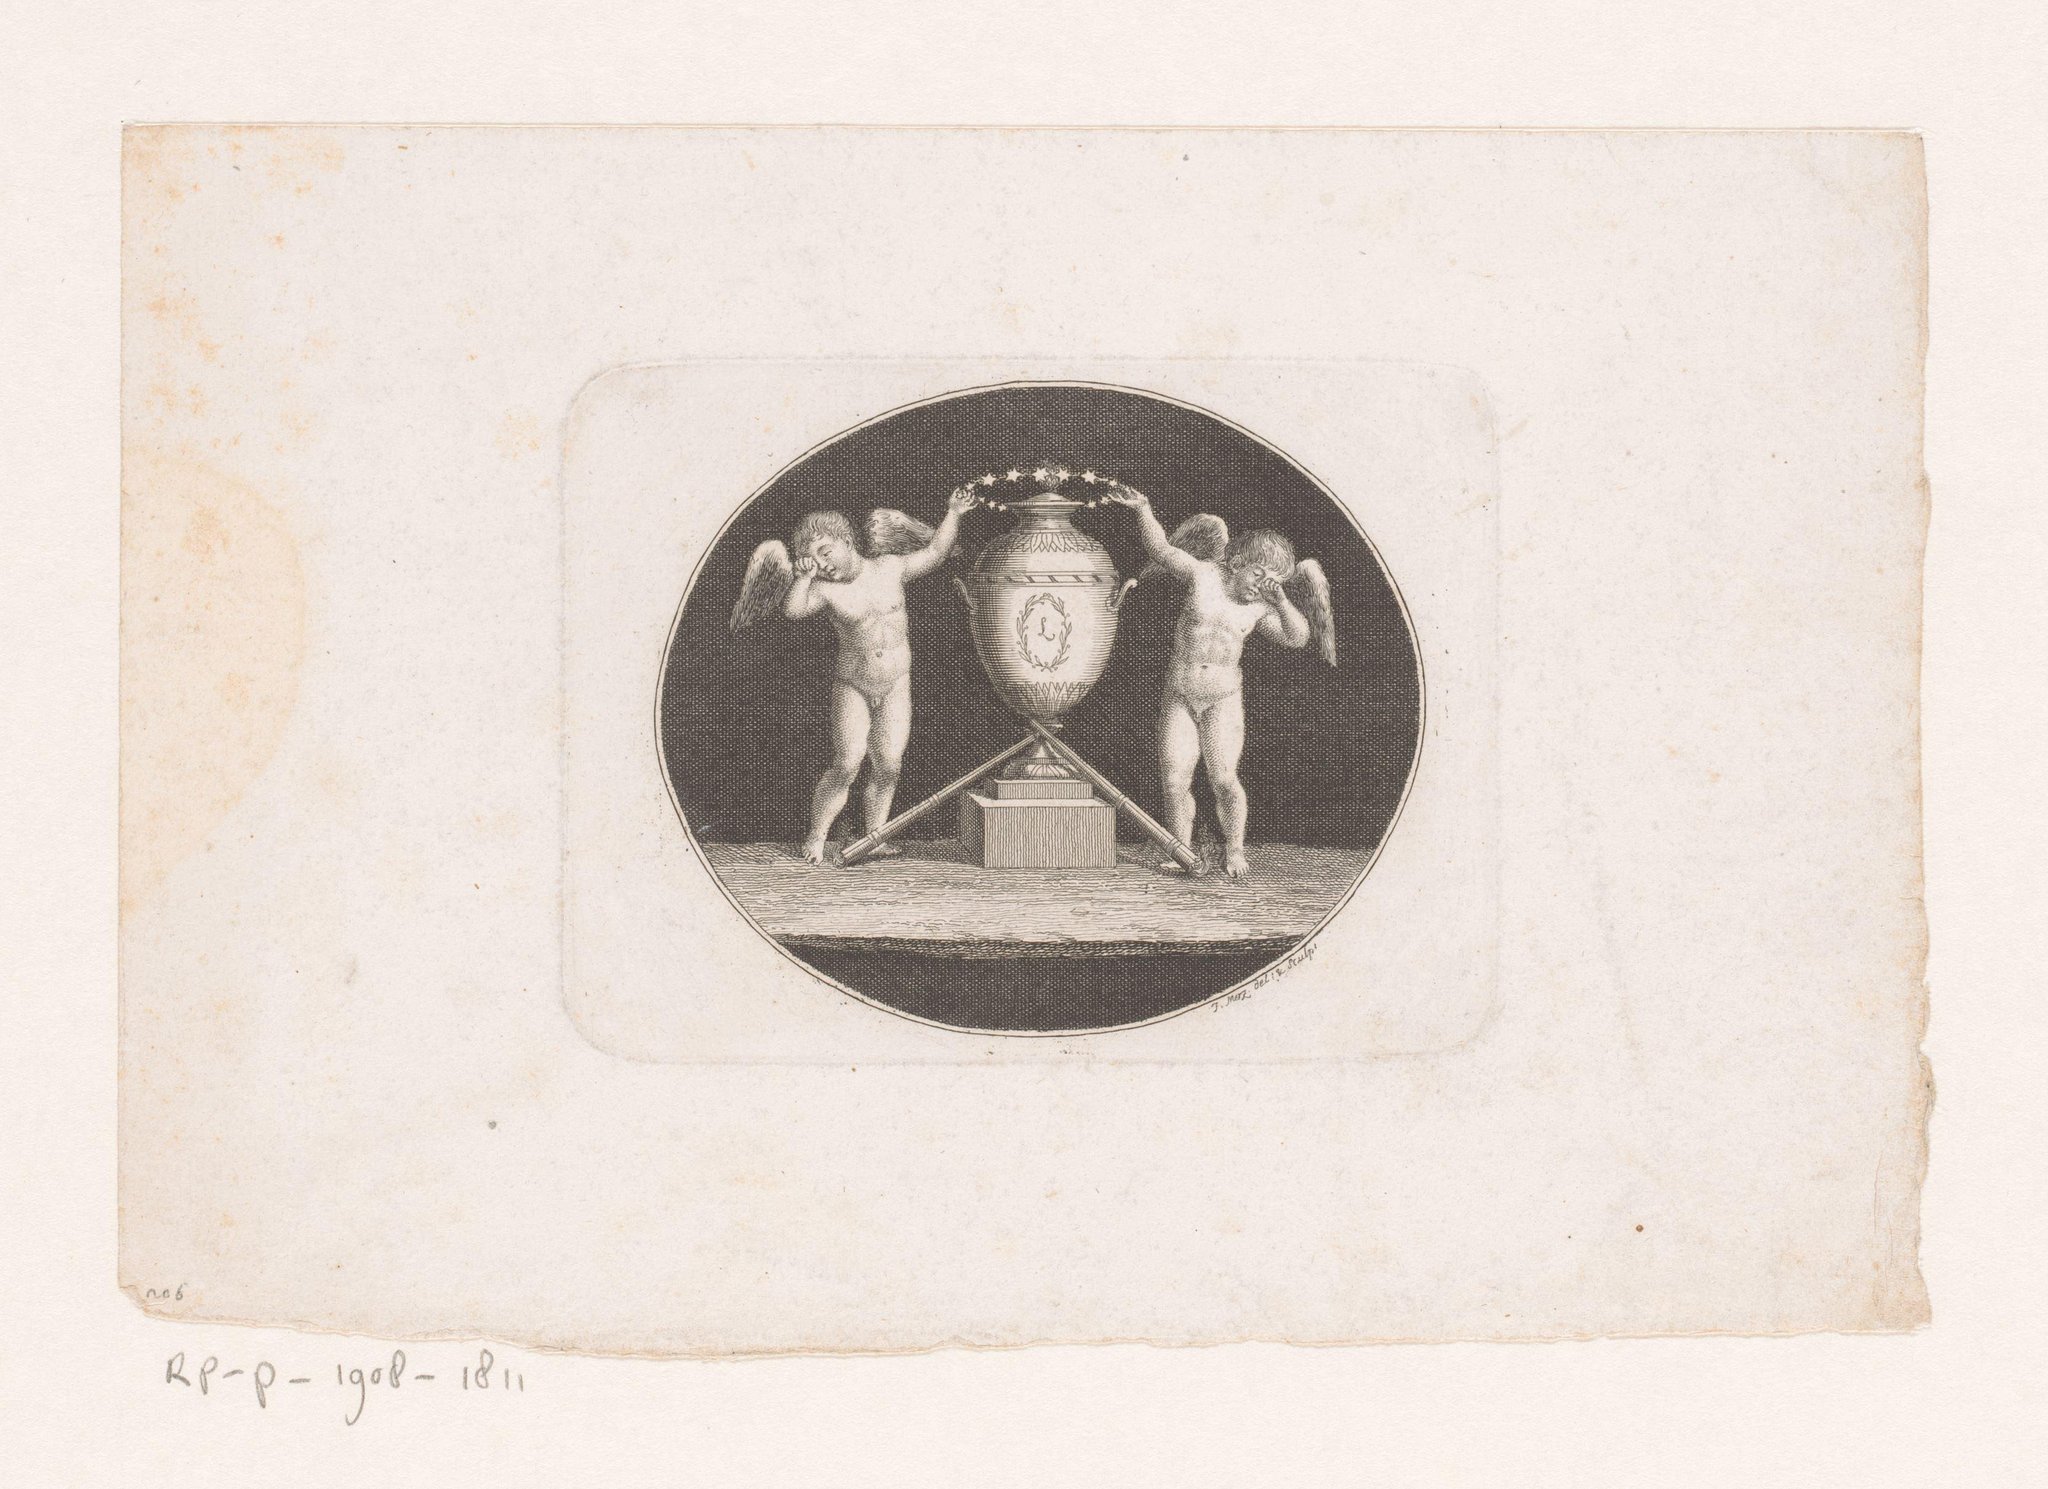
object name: print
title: Allegorie op de dood van Johann Kaspar Lavater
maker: jacob merz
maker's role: draughtsman, painter, print maker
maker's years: 1783-1807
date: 1801-1807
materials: paper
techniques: etching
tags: johann caspar lavater, torch - bb - torch held upside down, urn, cupids: 'amores', 'amoretti', 'putti'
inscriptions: collector's mark: Lugt 2228